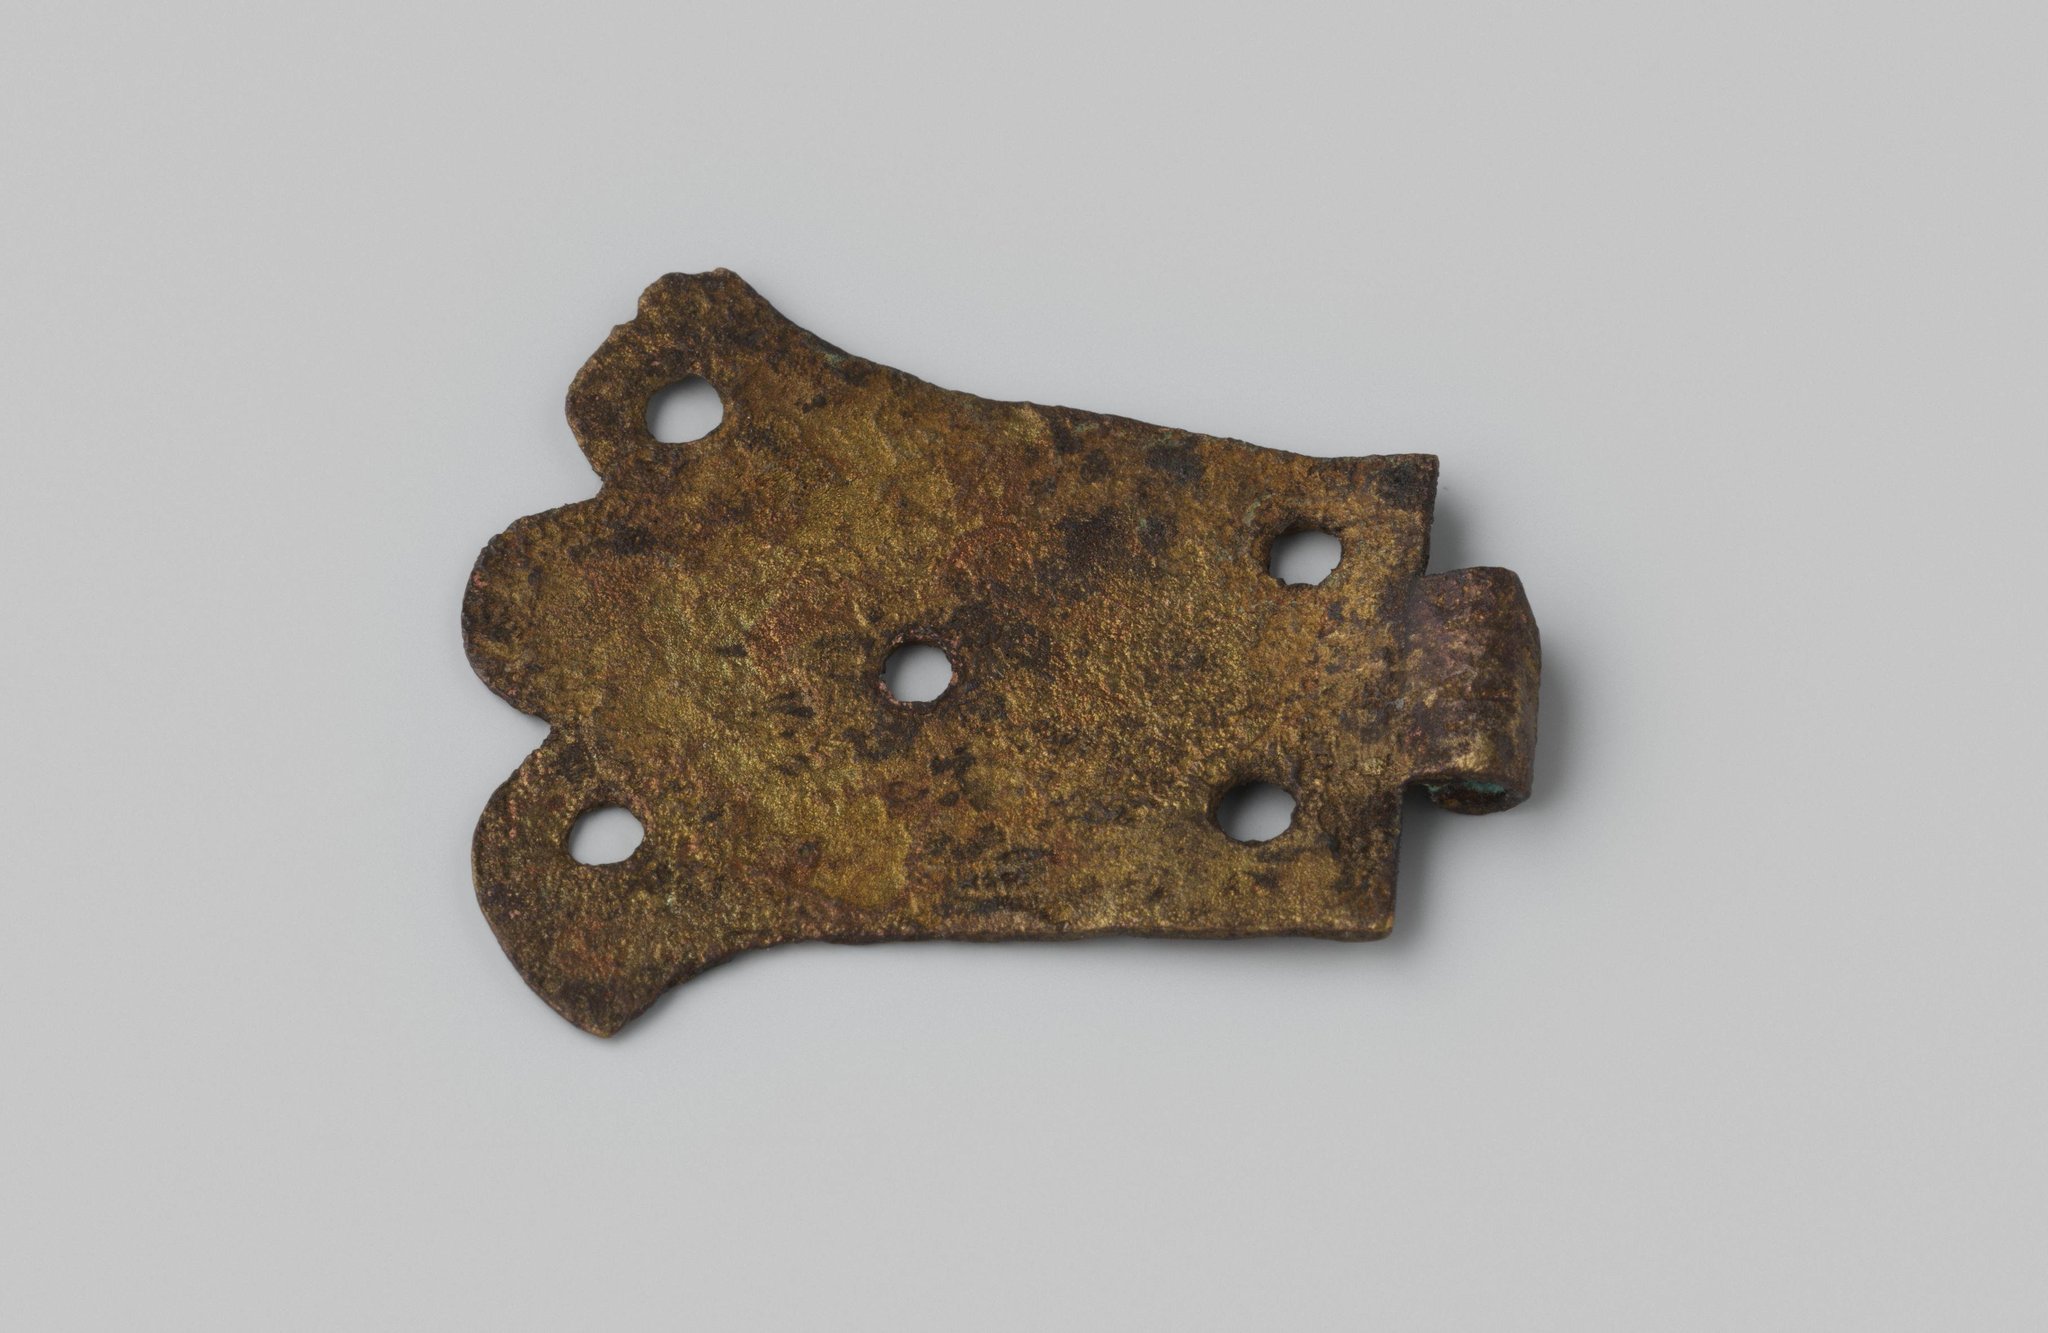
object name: scharnier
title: Slotscharnier uit het wrak van de Oost-Indiëvaarder Hollandia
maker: Anonymous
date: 1700-1743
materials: copper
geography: netherlands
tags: verenigde oostindische compagnie, hollandia (schip), annet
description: Hinge, fragm, three-lugged; flat plate, widened trifid end, 1 central lug, 5 holes.